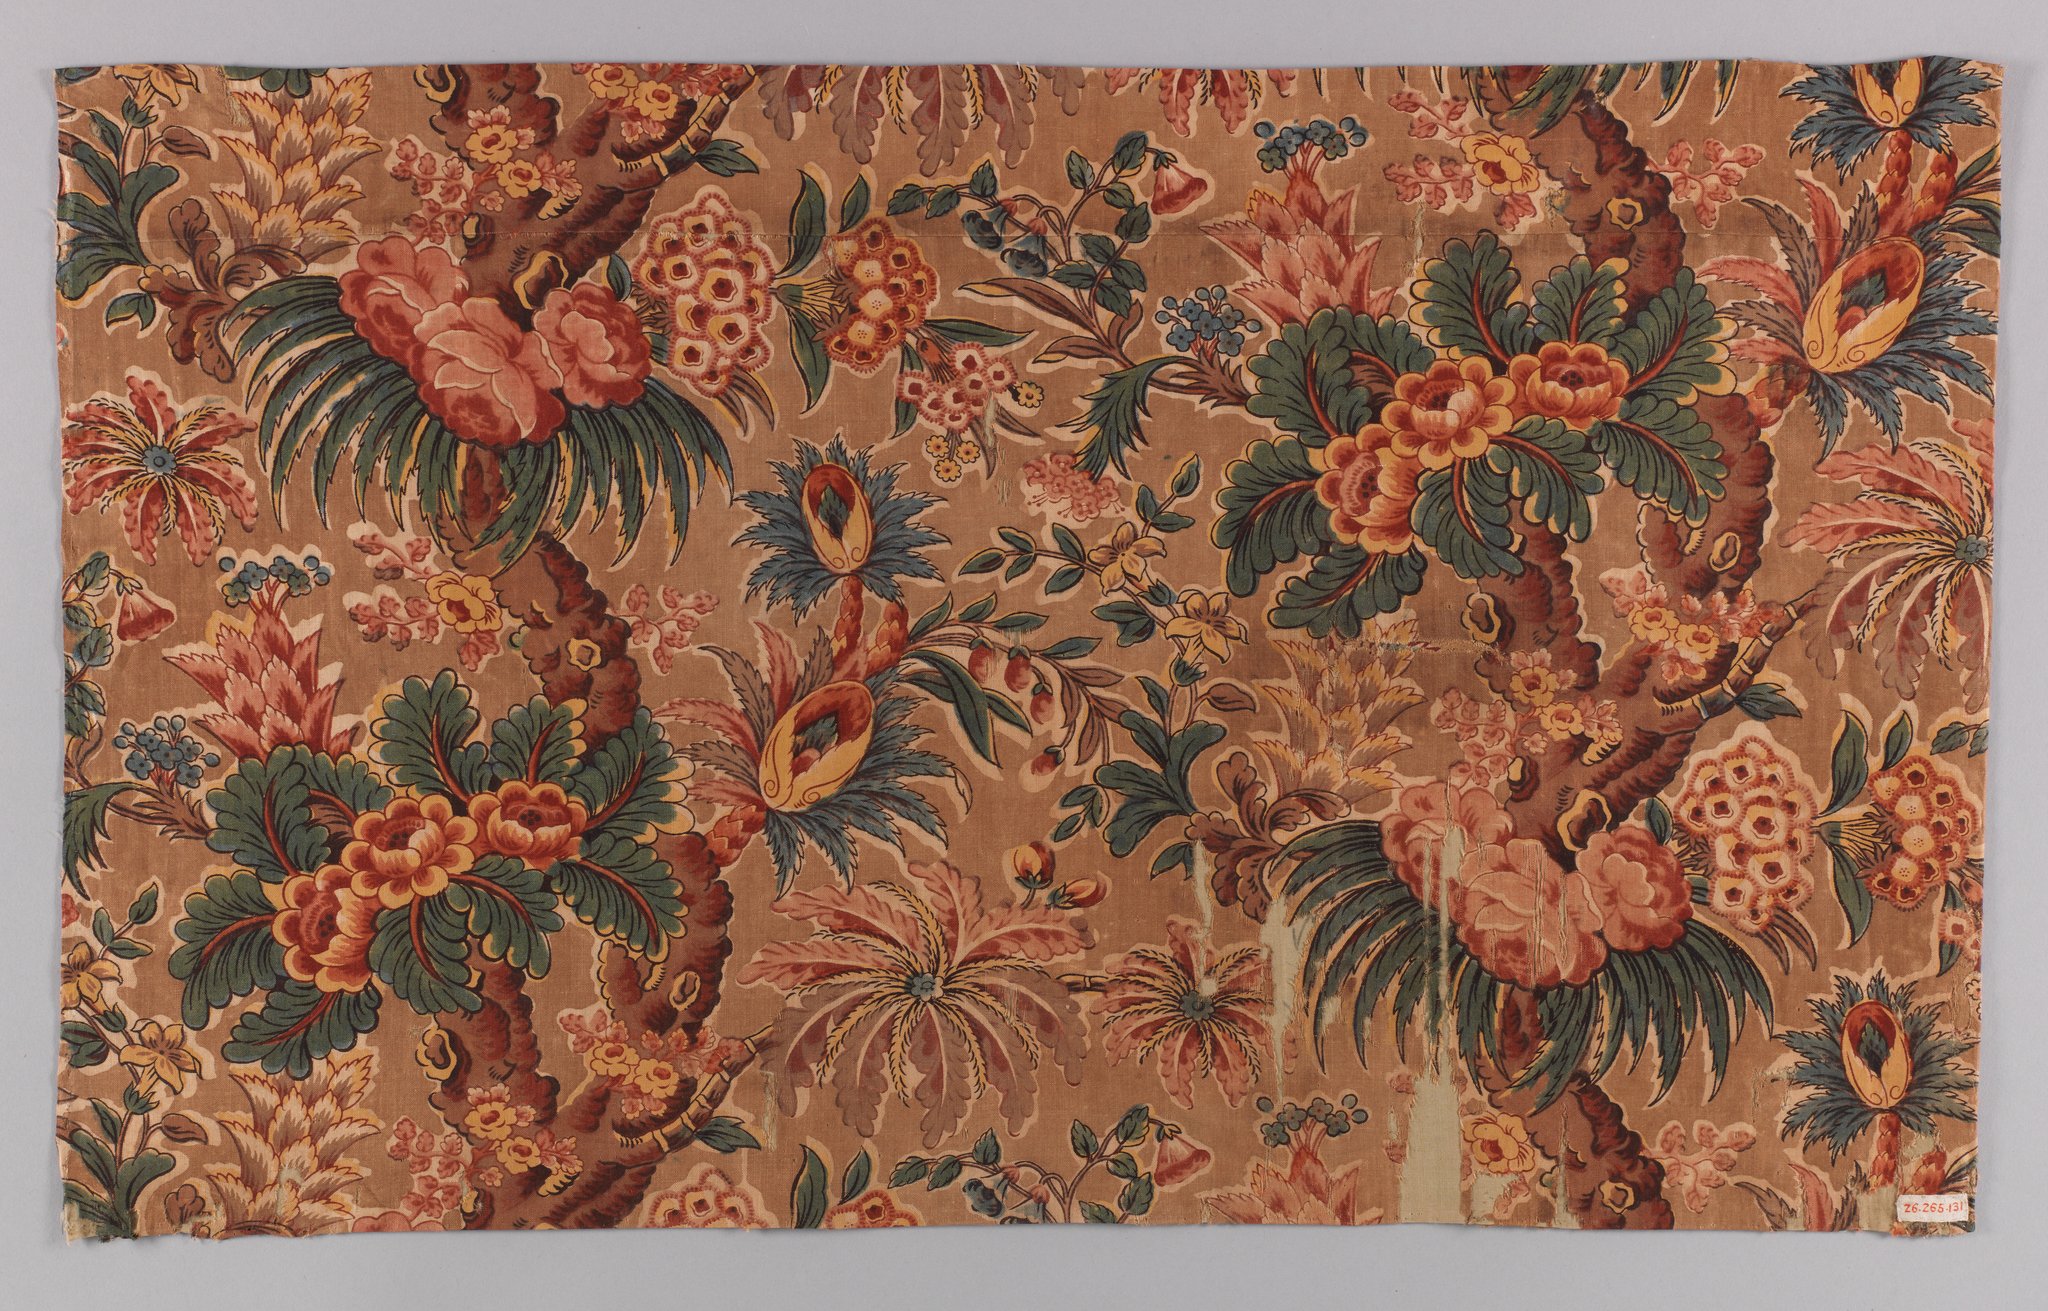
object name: floral print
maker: bannister hall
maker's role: manufactory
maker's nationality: british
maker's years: 1793-1893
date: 1815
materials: cotton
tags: flowers